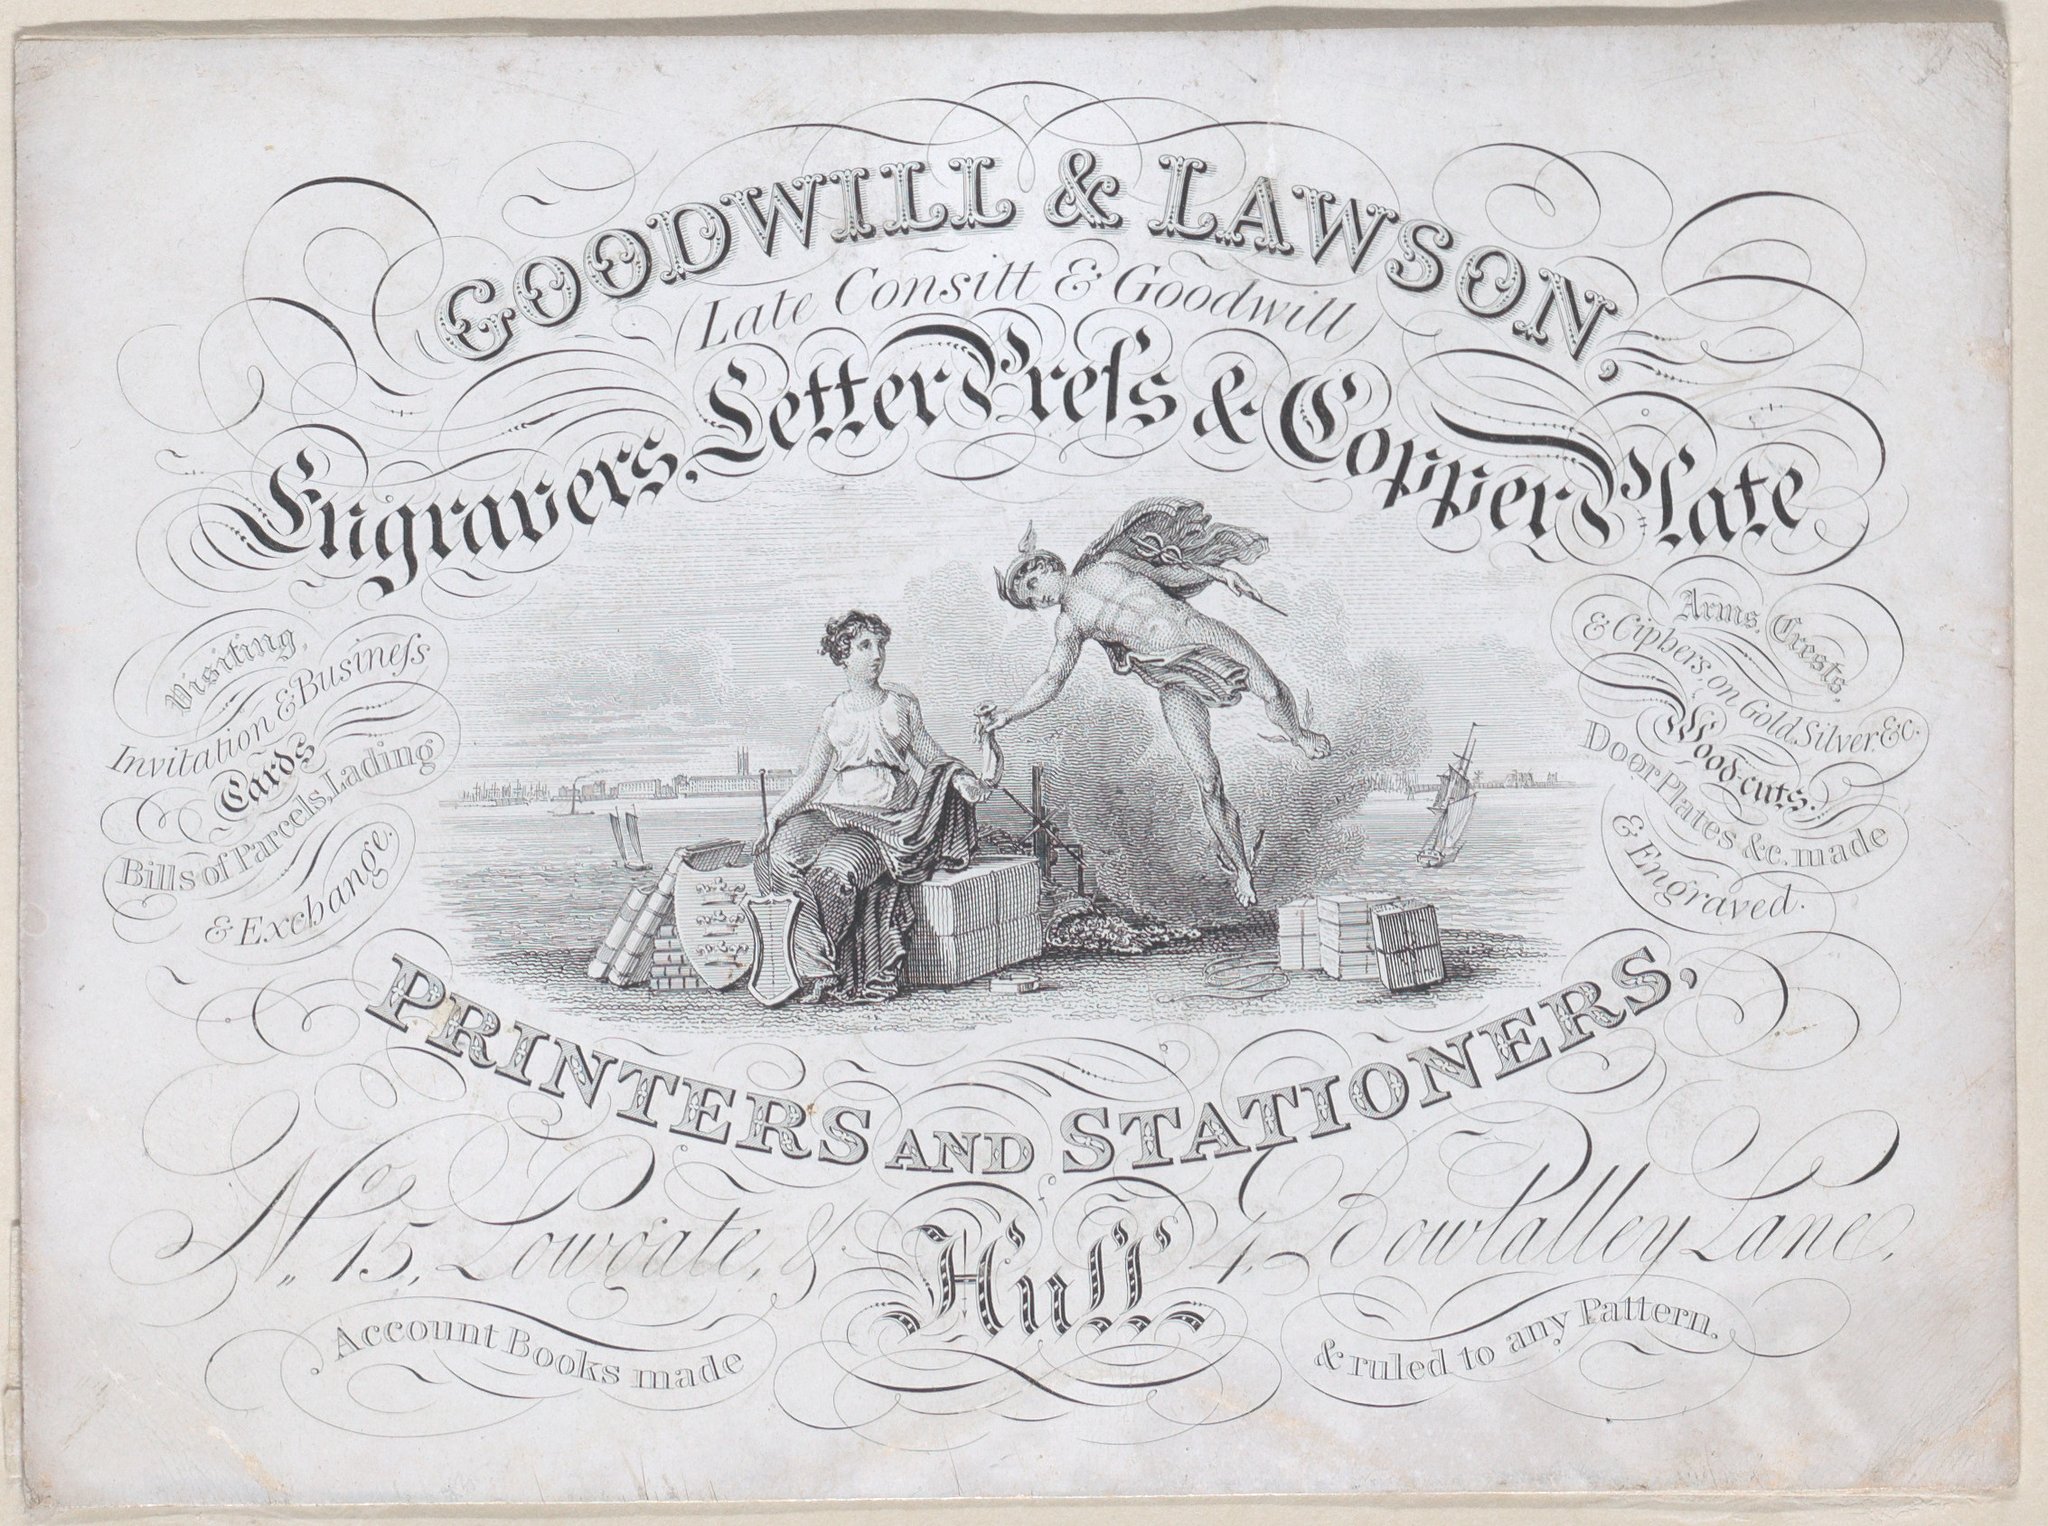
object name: print, trade card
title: Trade card for Goodwill & Lawson, engravers, printers and stationers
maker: anonymous, british, 19th century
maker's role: artist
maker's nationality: british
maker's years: 1800-1900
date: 1801-1900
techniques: engraving